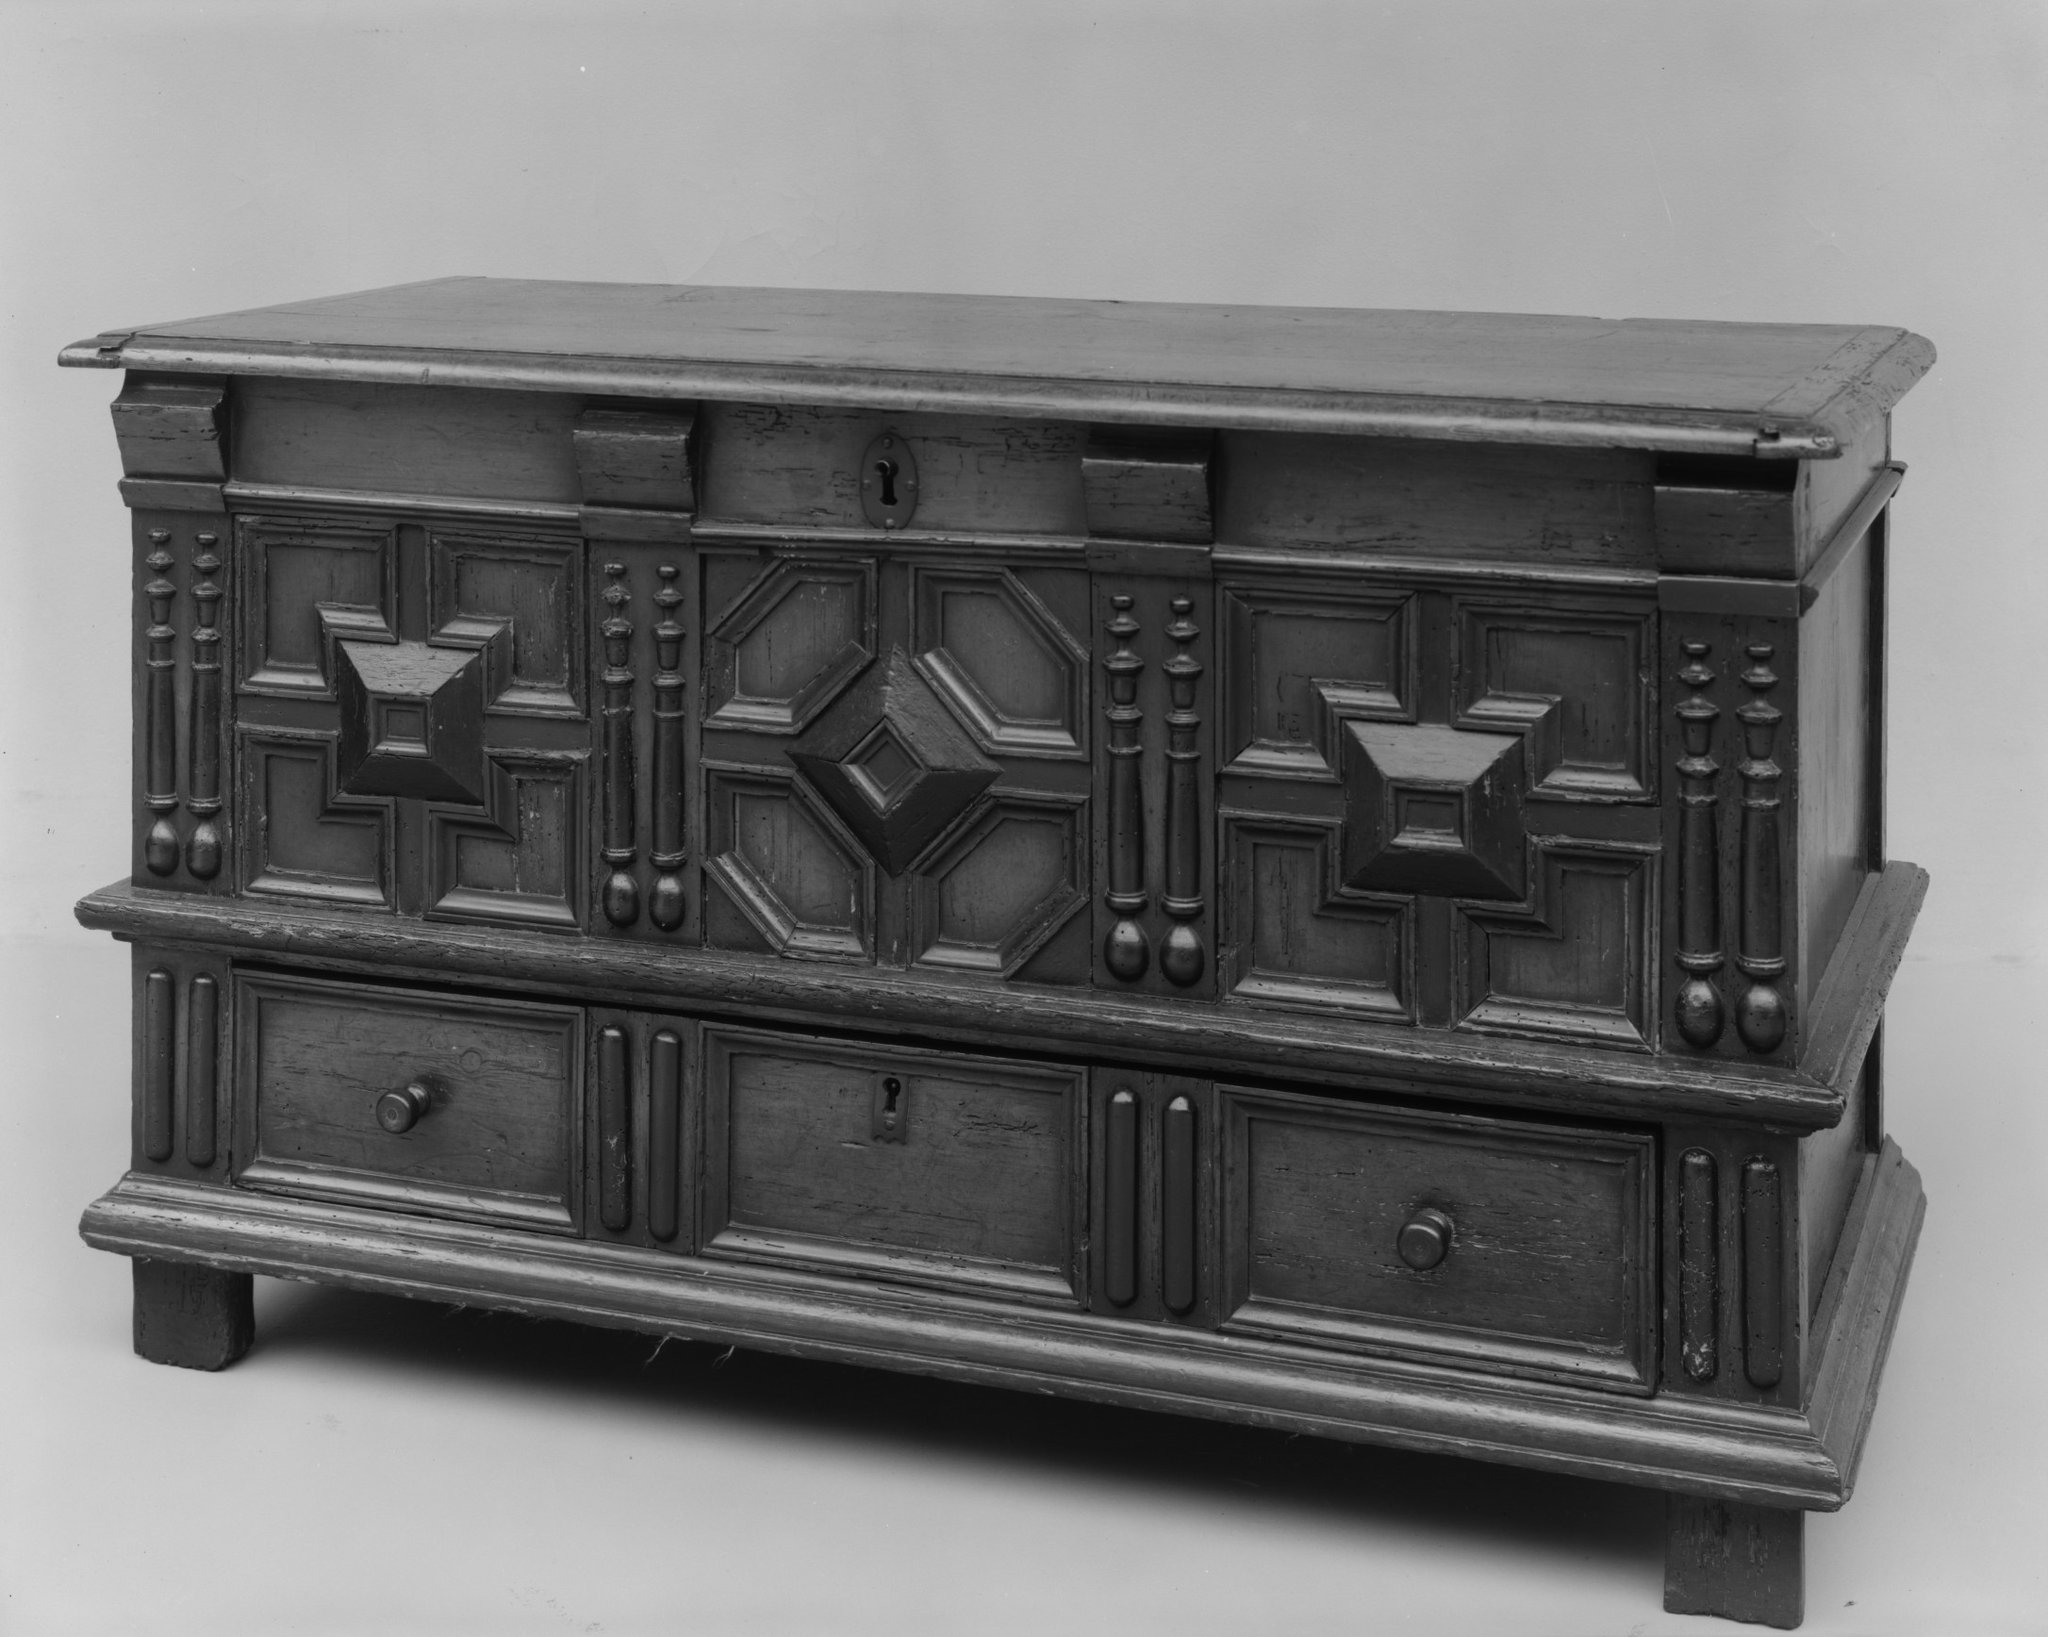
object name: chest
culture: british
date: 1650-1700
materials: wood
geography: england